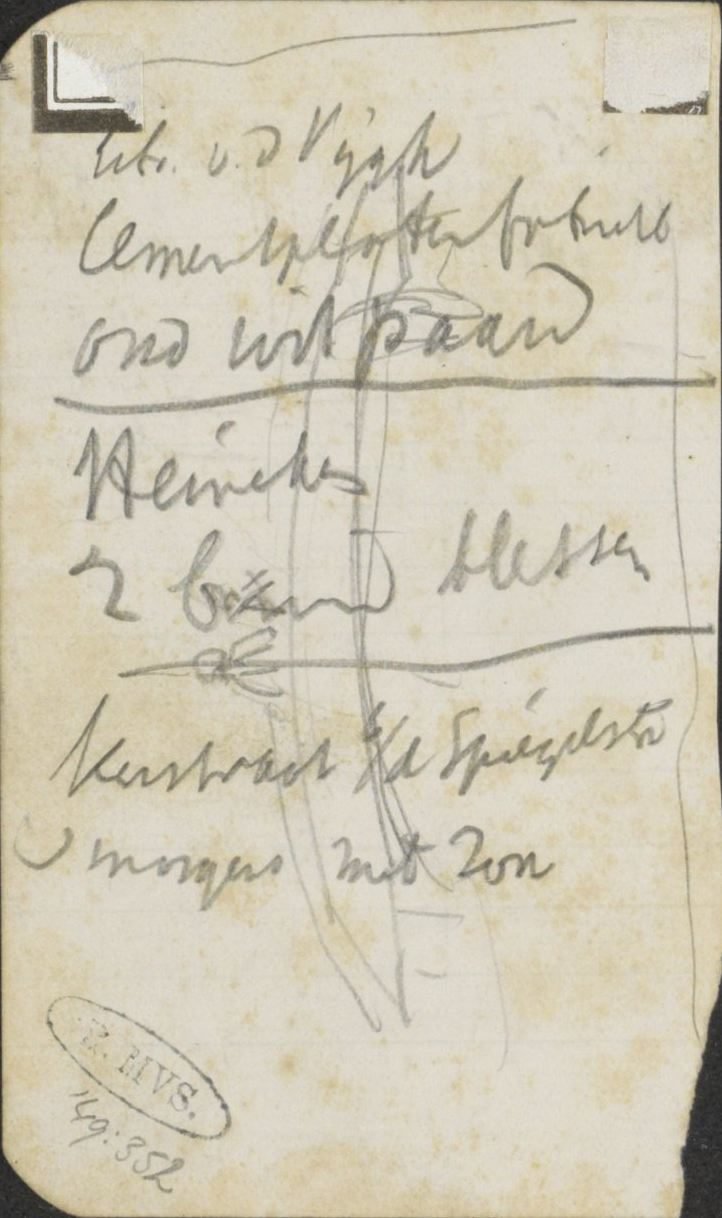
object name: drawing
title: Studie en annotaties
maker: george hendrik breitner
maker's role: draughtsman, painter, print maker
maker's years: 1857-1923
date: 1890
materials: pencil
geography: amsterdam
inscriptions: collector's mark: Lugt 2228, annotation: ‘[...]/ Kerkstraat b/d Spiegelstr/ 's morgens met zon’, workshop stamp: Lugt 291d